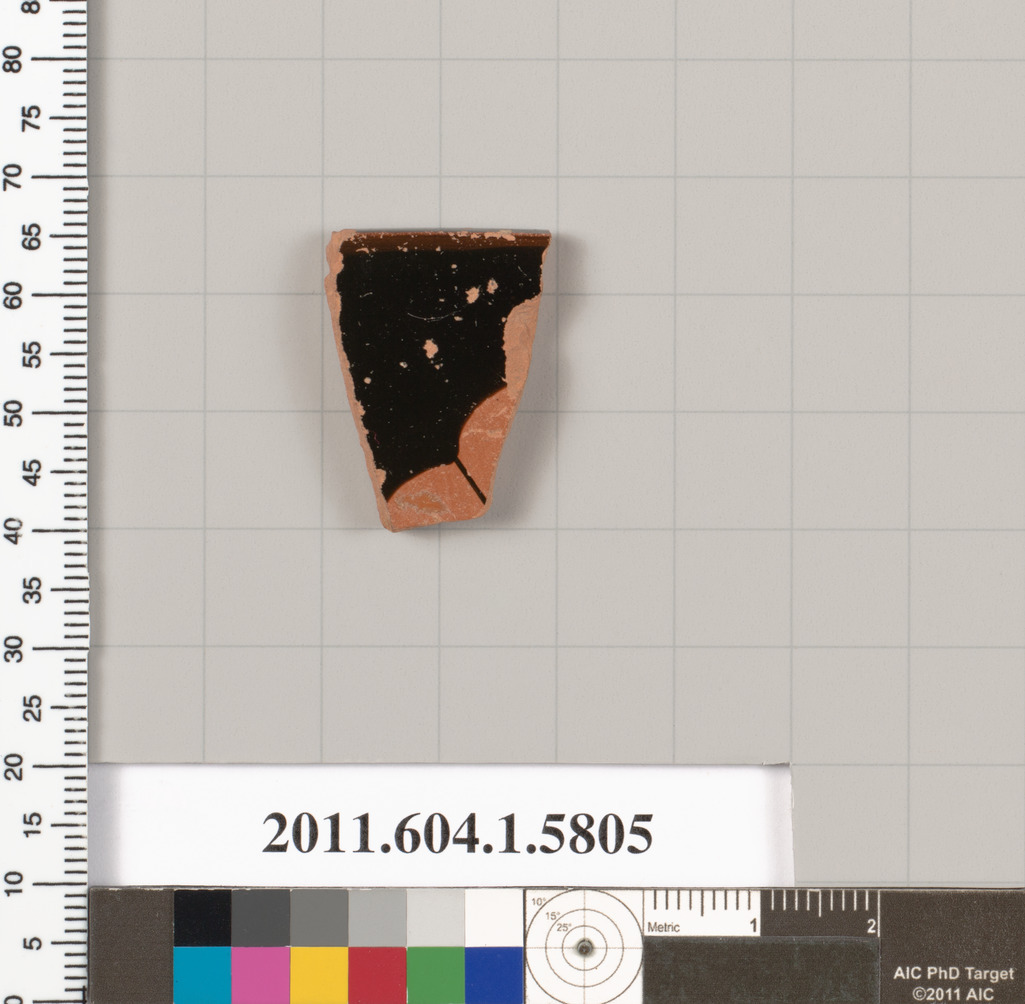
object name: kylix fragment, eye cup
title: Terracotta fragment of a kylix: eye-cup (drinking cup)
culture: greek, attic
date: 520-510 BCE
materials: terracotta